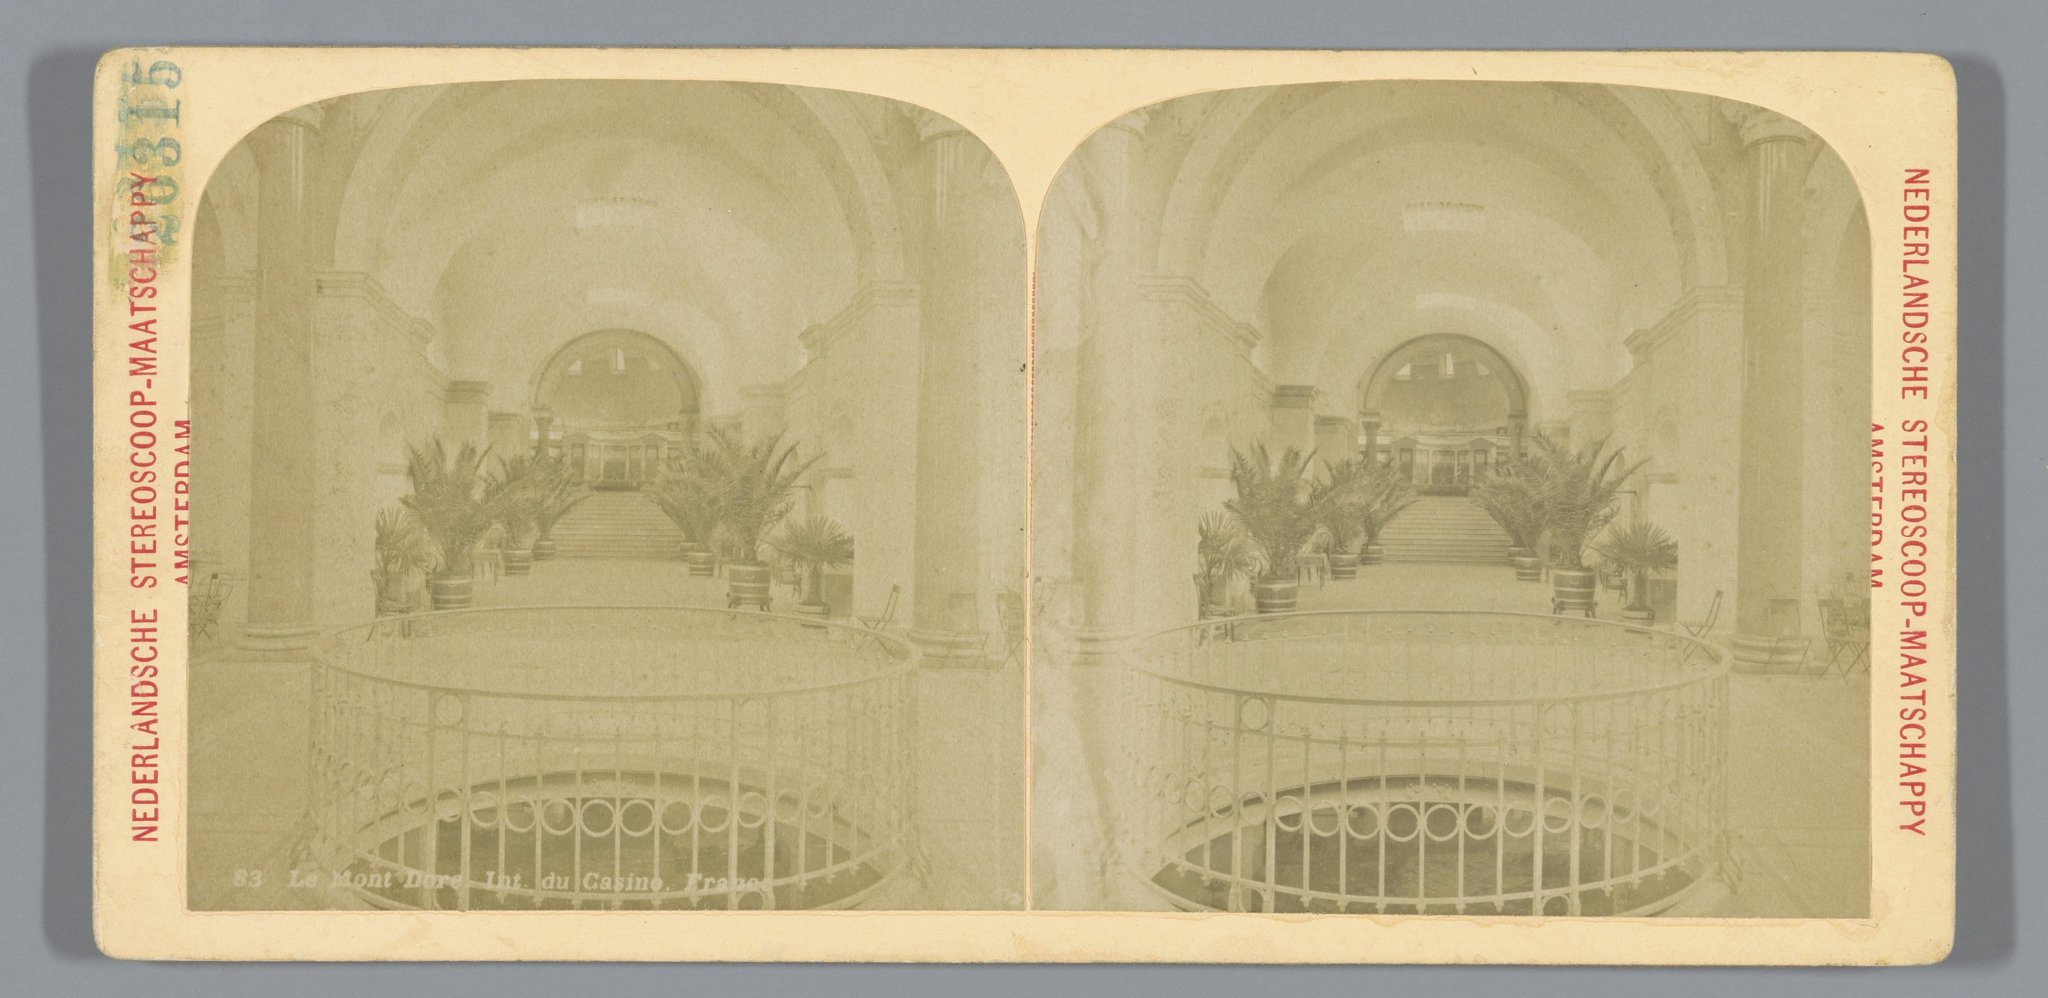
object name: stereograph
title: Le Mont Dore. Int. du Casino. France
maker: j.g. beers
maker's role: fotograaf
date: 1850-1880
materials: cardboard, photographic support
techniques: albumen print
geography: amsterdam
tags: casino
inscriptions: number: ‘26315’, number: ‘83’